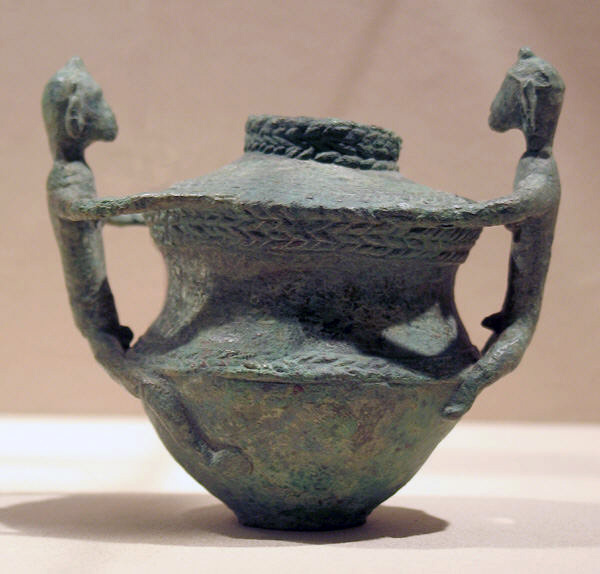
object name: container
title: Lime Container with Figural Handles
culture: indonesian, javanese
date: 500 BCE-300 CE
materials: bronze